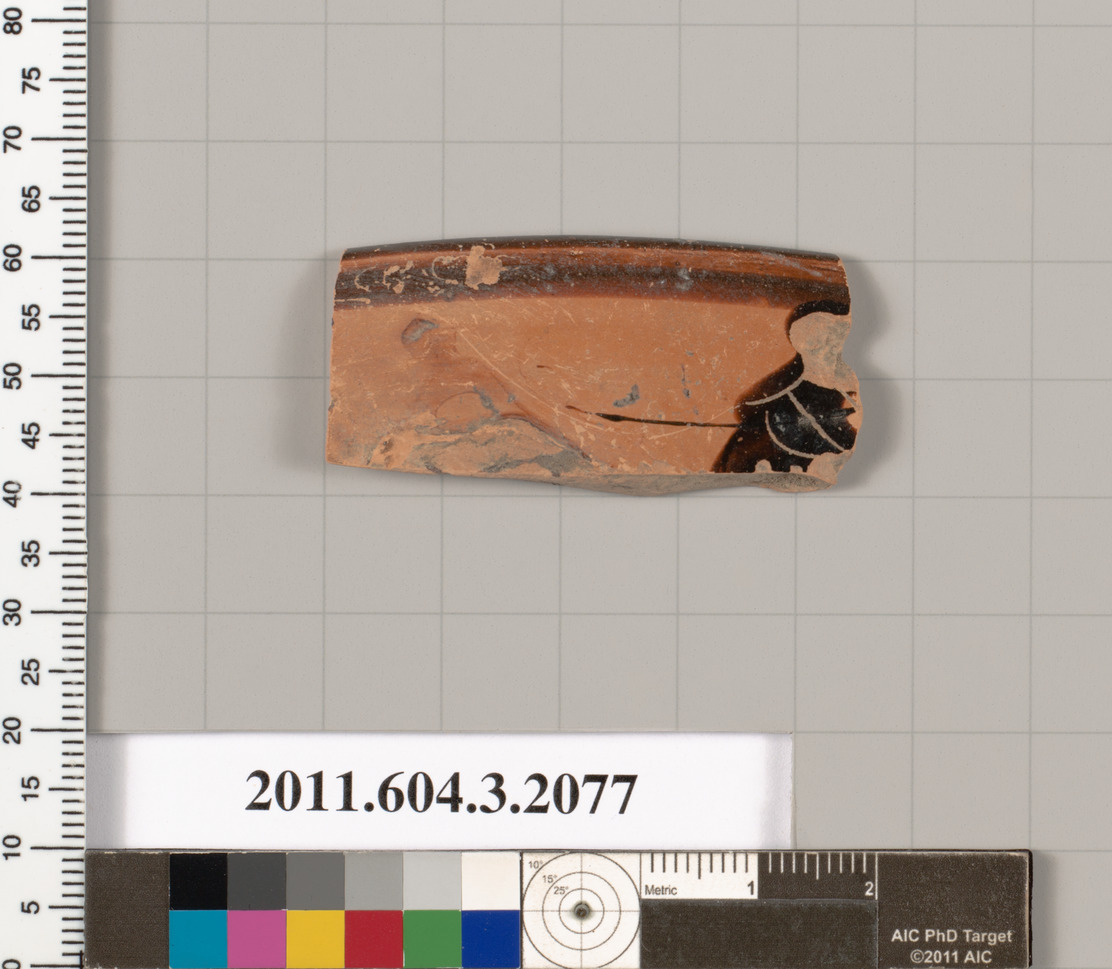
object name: kylix fragment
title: Terracotta rim fragment of a kylix (drinking cup)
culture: greek, attic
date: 534-468 BCE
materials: terracotta